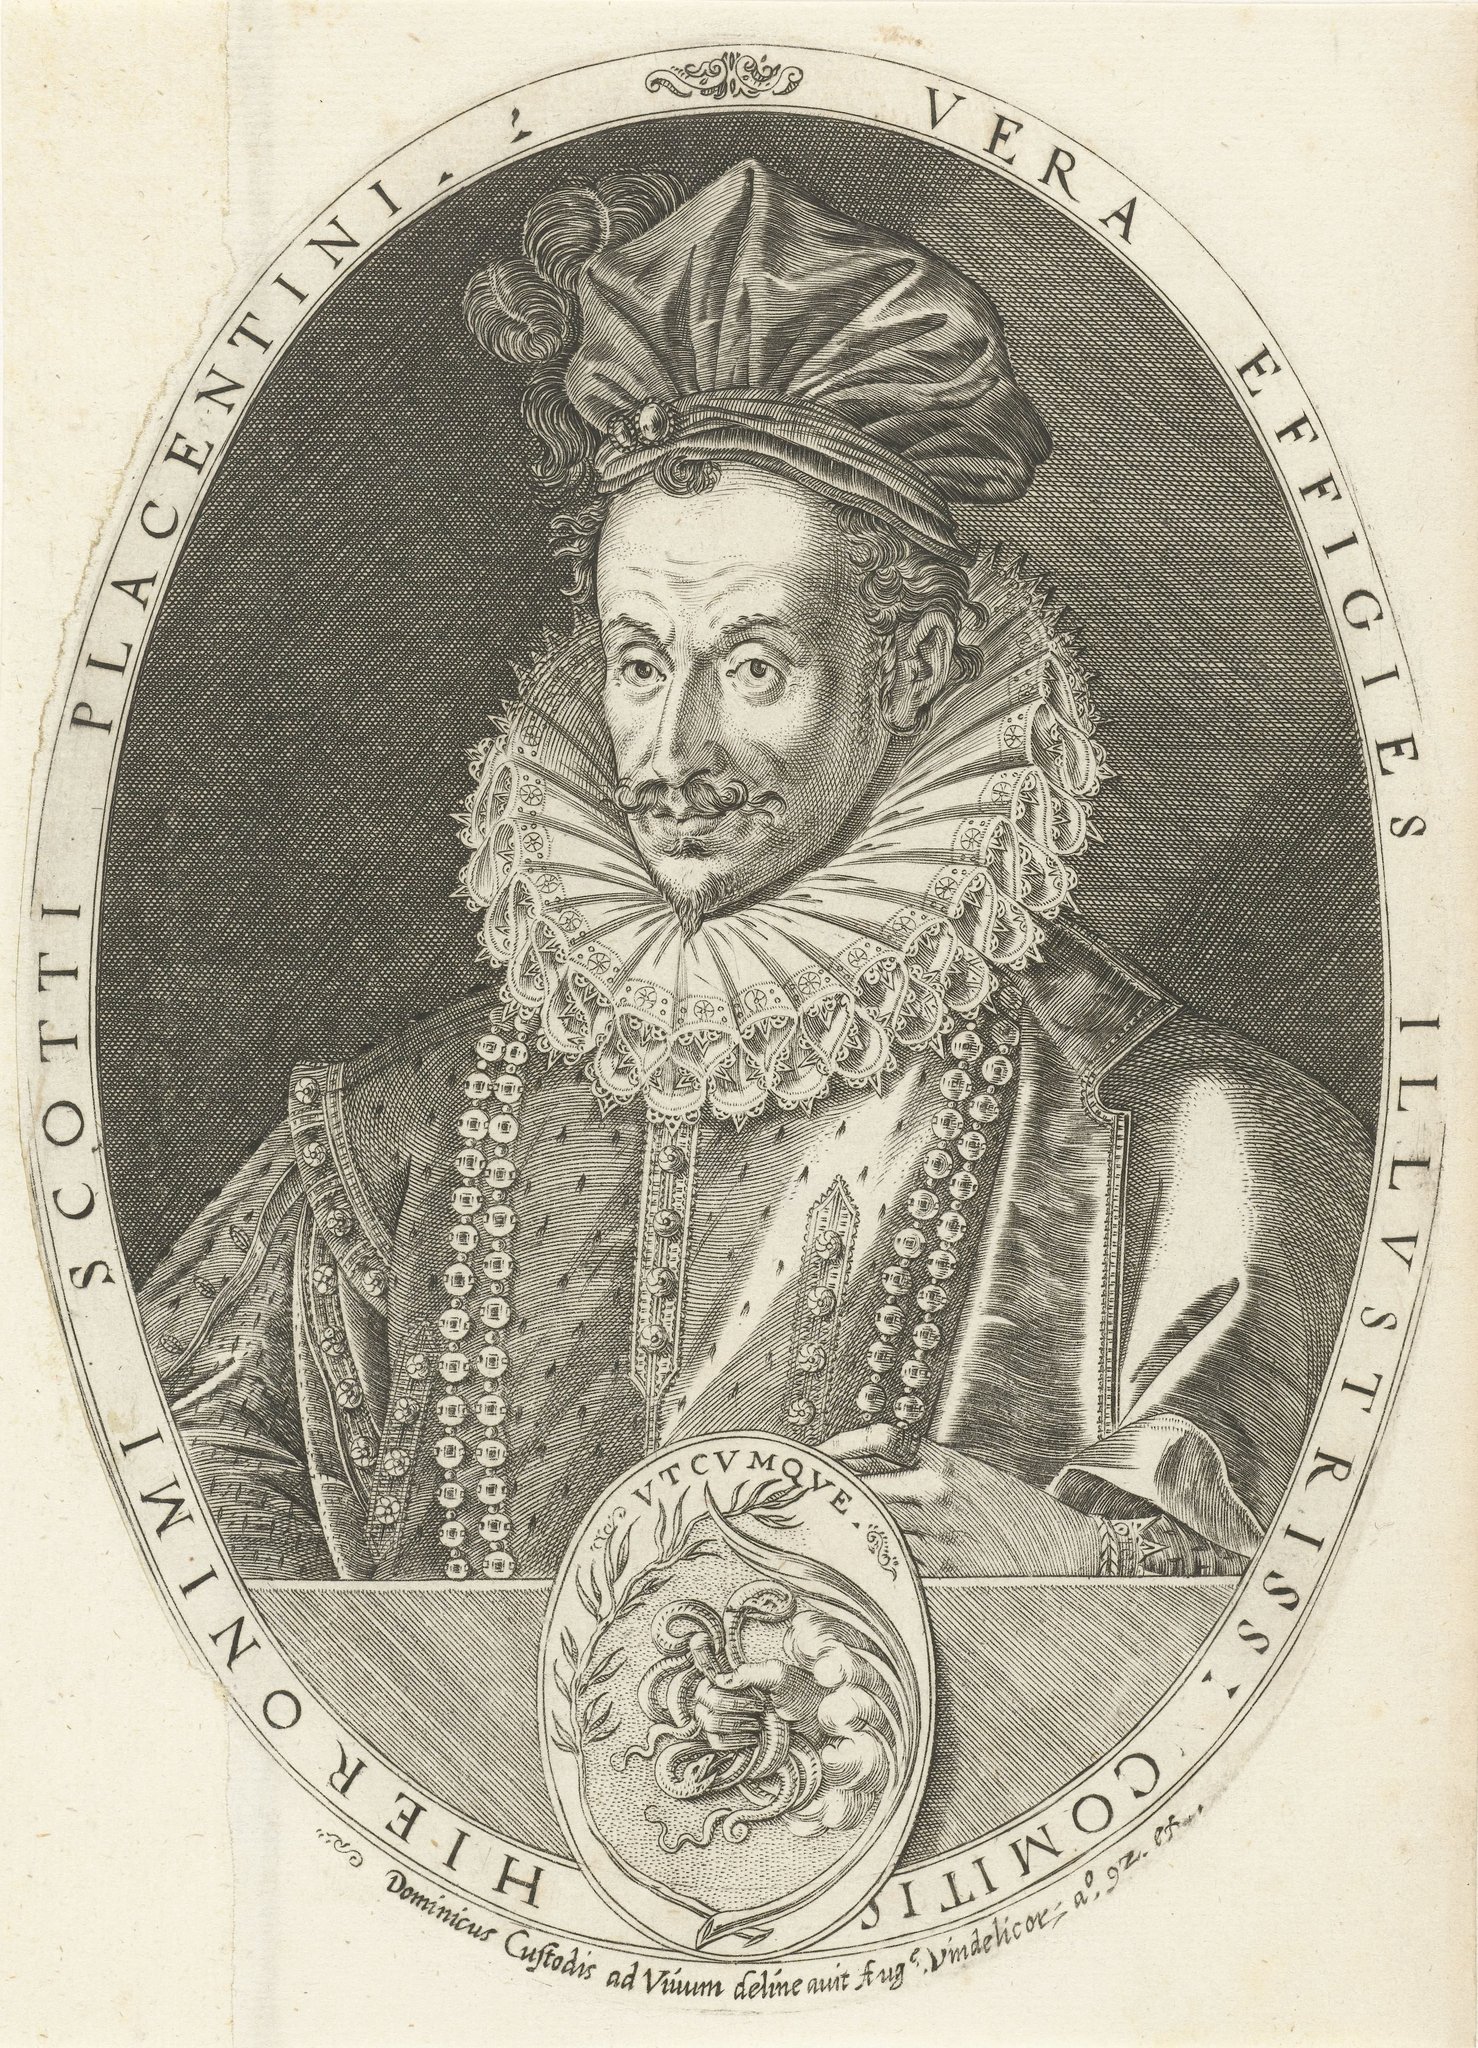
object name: print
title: Portret van Hieronymus Scotius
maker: dominicus custos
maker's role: print maker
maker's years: 1560-1615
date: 1592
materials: paper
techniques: engraving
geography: augsburg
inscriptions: collector's mark: Lugt 2228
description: Portret van de avonturier Hieronymus Scotus, in ovaal met randschrift. Onder het portret een schild met een hand die in een slangenkuil grijpt en het motto: "Ut cum que".